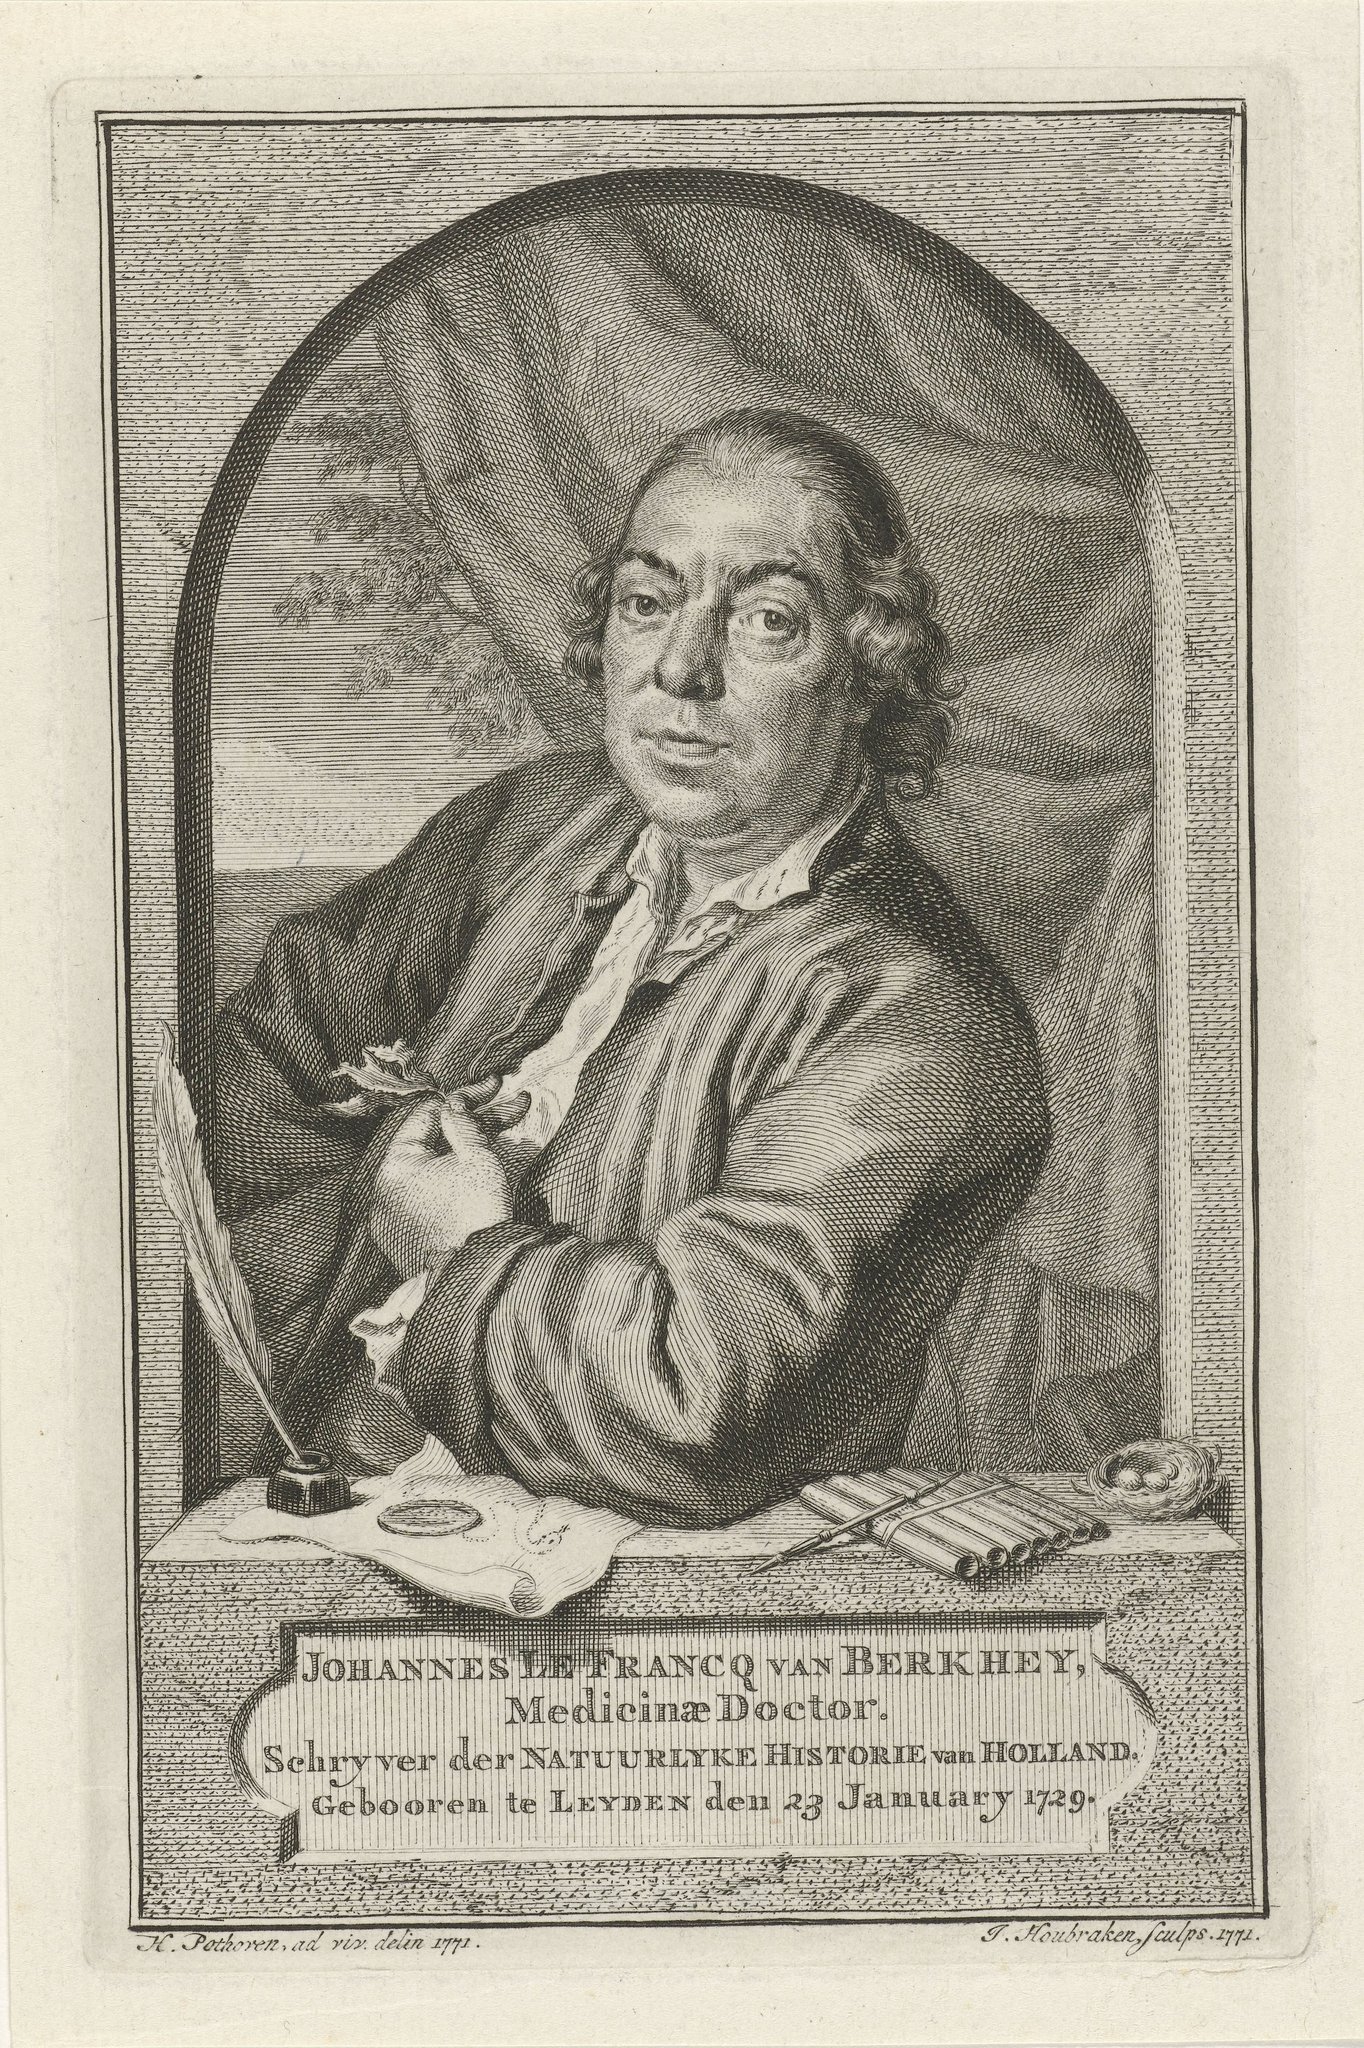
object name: print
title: Johannes Le Francq van Berkhey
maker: jacob houbraken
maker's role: draughtsman, print maker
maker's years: 1698-1780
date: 1771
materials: paper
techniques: engraving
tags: leiden, print maker, draughtsman, johannes le francq van berkhey, ink-well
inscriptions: collector's mark: Lugt 240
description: Portret ten halven lijve naar links van Johannes le Francq van Berkhey, in een architectonische omlijsting, zijn linkerarm rustend op een plint. Daaronder zijn naam en gegevens in vier regels in het Nederlands. Op de plint een vogelnestje en schrijfgerei, in zijn hand een blaadje.